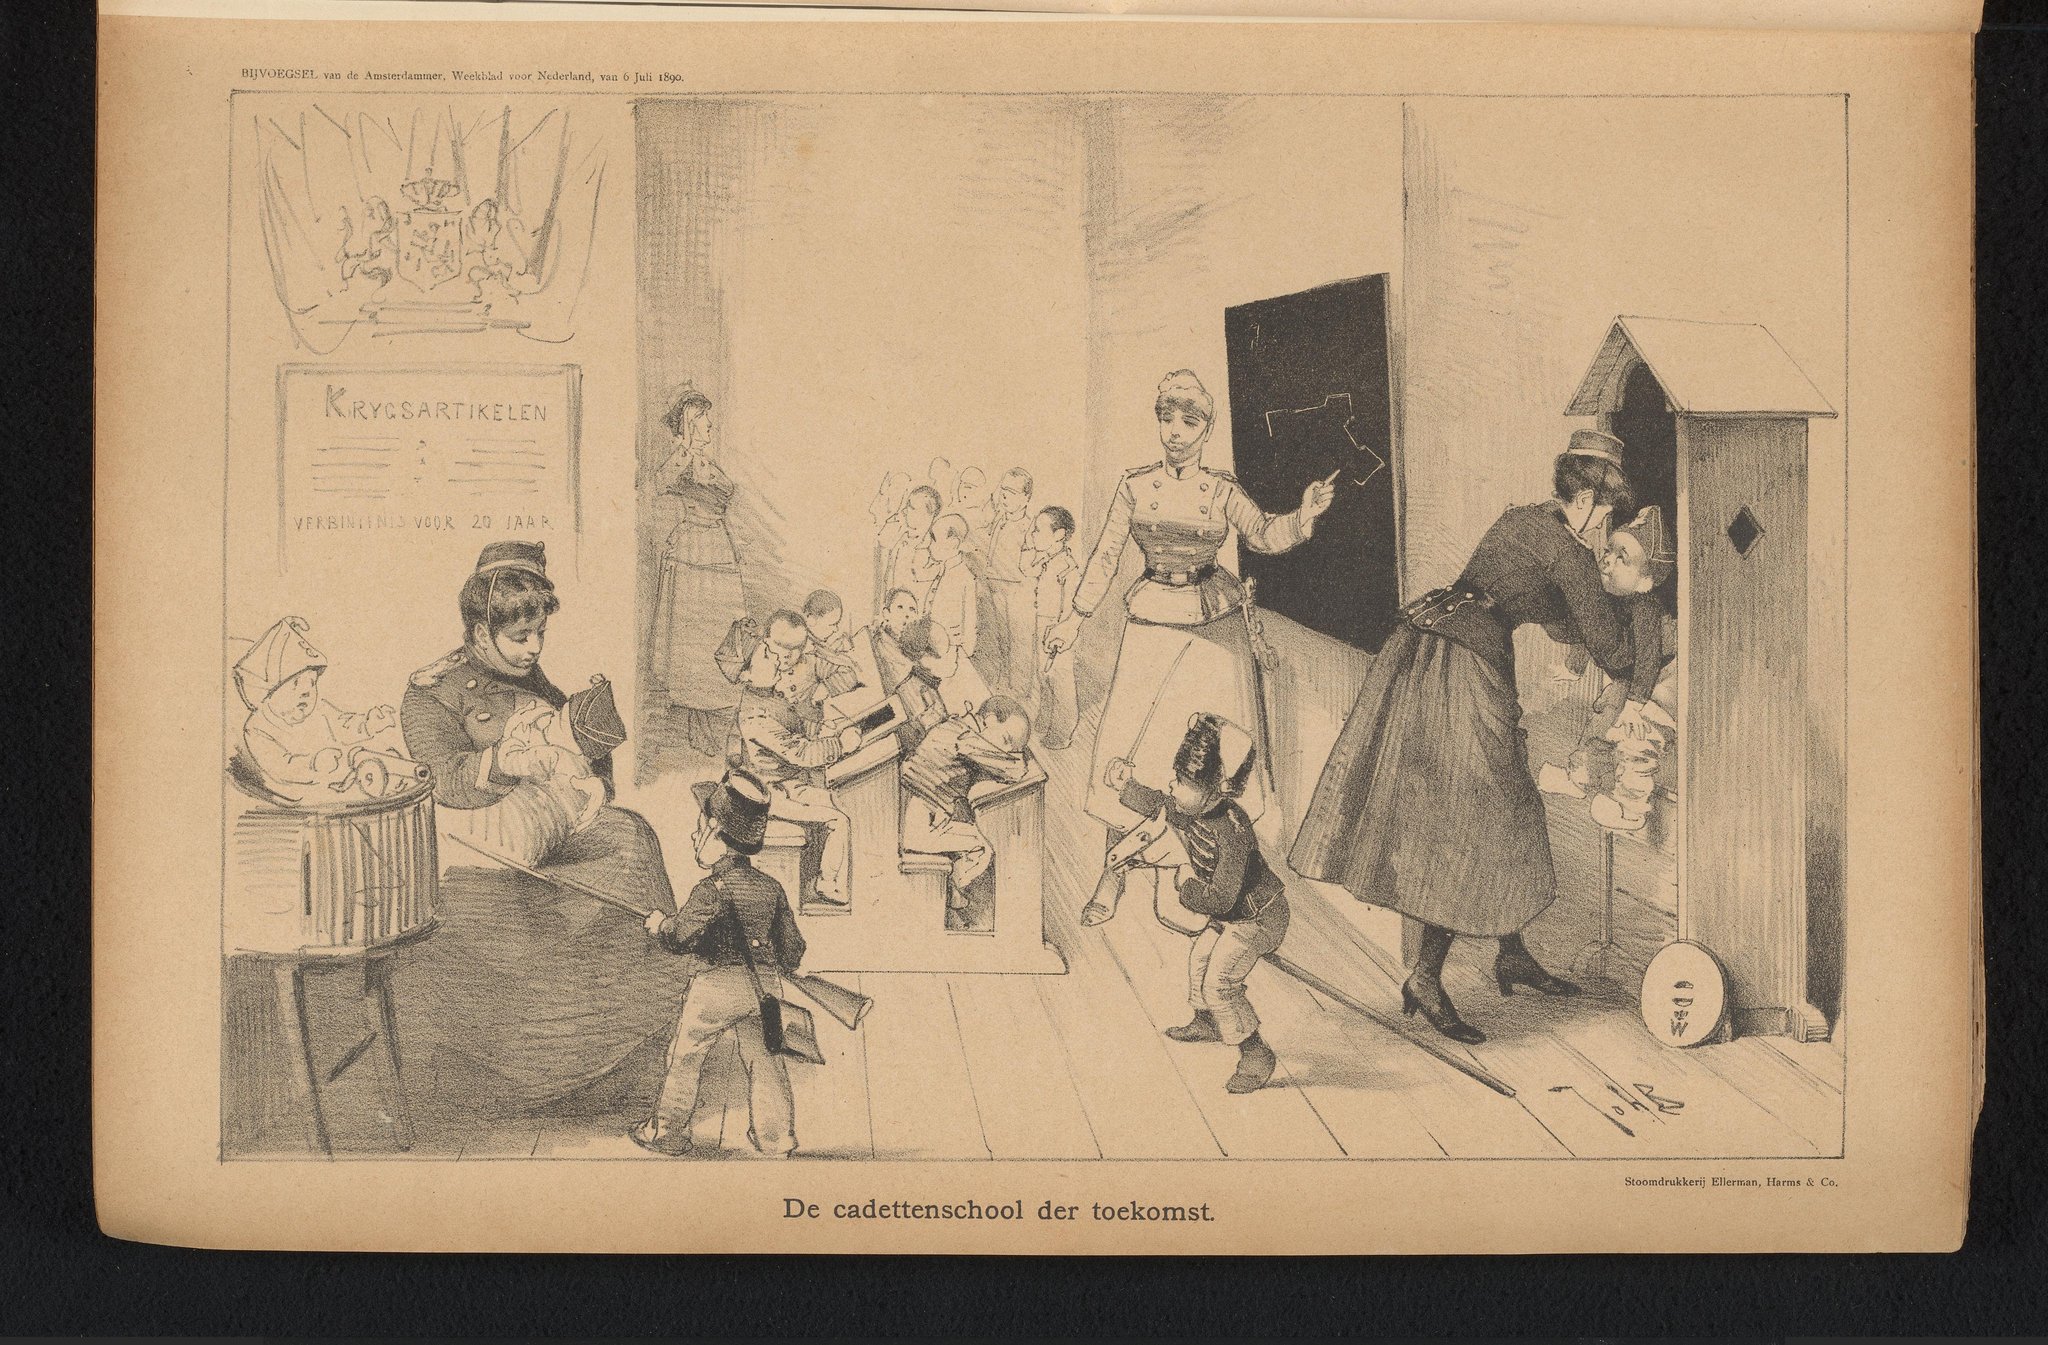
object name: cartoon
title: De cadettenschool der toekomst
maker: johan braakensiek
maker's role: draughtsman, print maker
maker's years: 1858-1940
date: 1890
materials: paper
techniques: lithograph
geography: netherlands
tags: nursing, suckling, military training, nursery school, political caricatures and satires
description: Kleuterschool waar de cadetten van zeer jongs af aan opgeleid worden tot militair. Links krijgt een cadet de borst, rechts wordt een cadet op het toilet gezet.